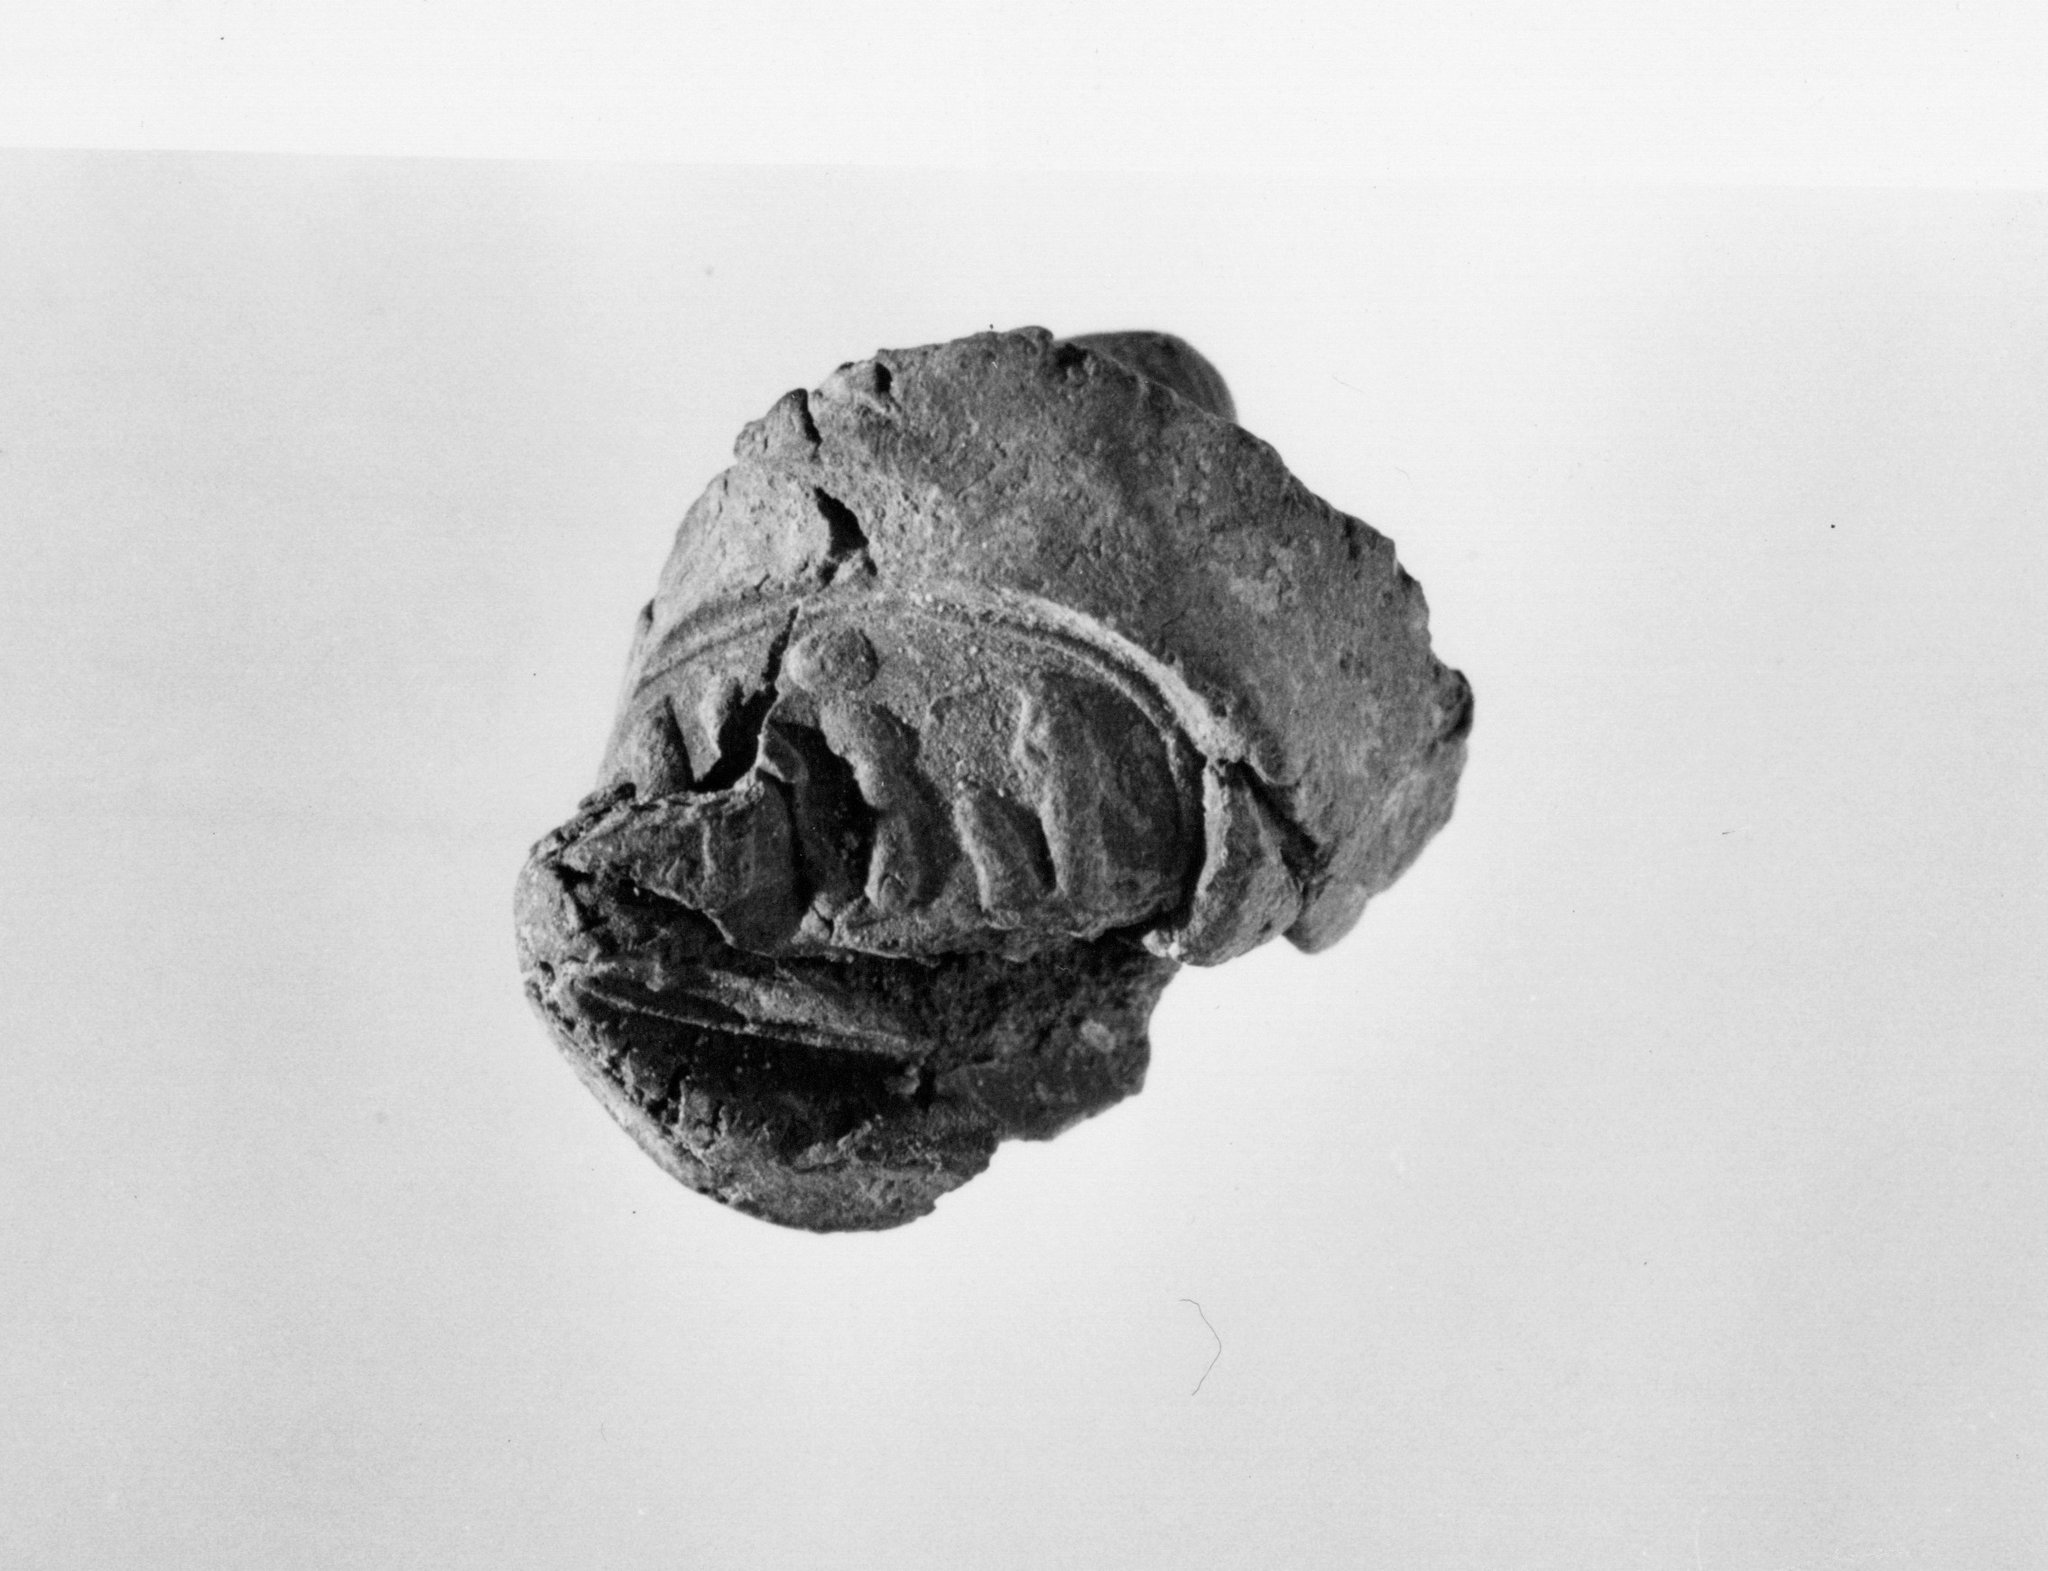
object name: sealing, nebmaatre, amenhotep iii, horus, re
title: Document Sealing With the Throne Name of Amenhotep III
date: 1390-1352 BCE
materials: mud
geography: egypt